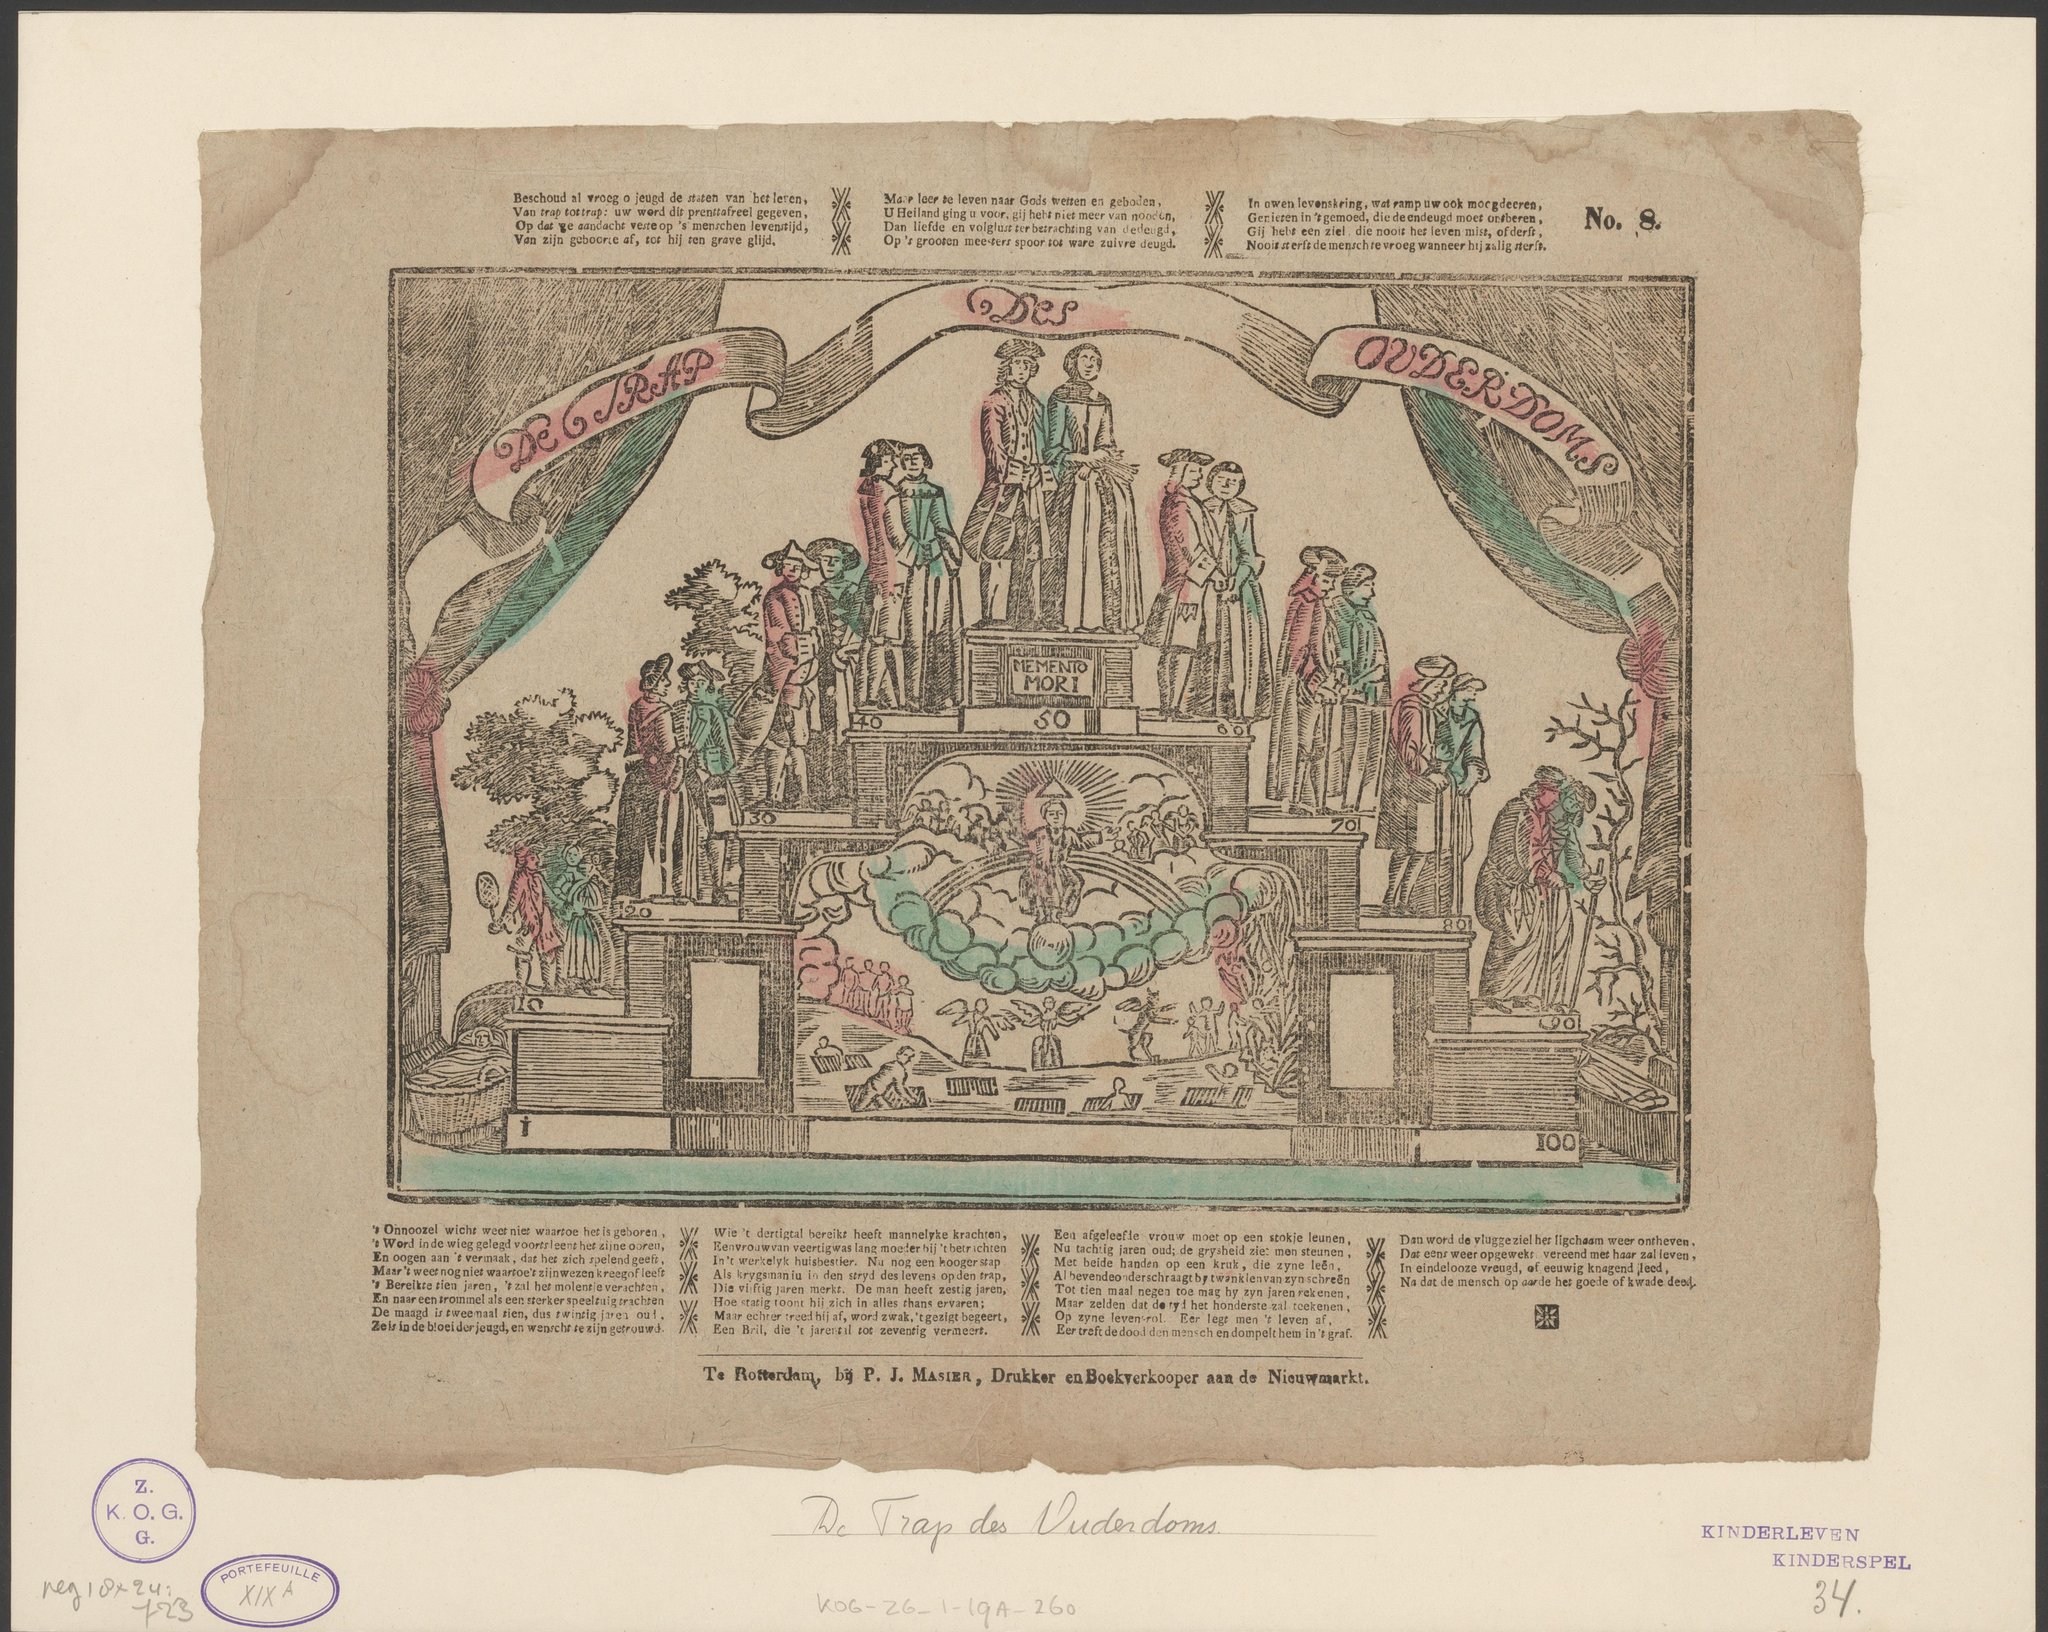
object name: print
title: Trap der ouderdoms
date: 1827-1860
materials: paper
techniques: hand coloring, letterpress printing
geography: rotterdam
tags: last judgement, the ages of man represented by a staircase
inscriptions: collector's mark: Lugt 1641, stamp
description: Een trap des ouderdoms: een parentrap. Op de treden van de trap, in de vorm van een brug, staan mannen en vrouwen in de leeftijd van 0 tot 100 jaar. Onder de brug een voorstelling van het Laatste Oordeel. Aan weerszijden van de voorstelling een gordijn. Boven de afbeelding een vers in drie kolommen, onder de afbeelding een vers in vier kolommen. Genummerd rechtsboven: No. 4. Onderwerpsrubrieken binnen de Atlas Zeden en Gewoonten: Zeden en Gewoonten in Engeren Zin, Des menschen beging, midden en einde, Kinderleven – Kinderspel en Kinderprenten.